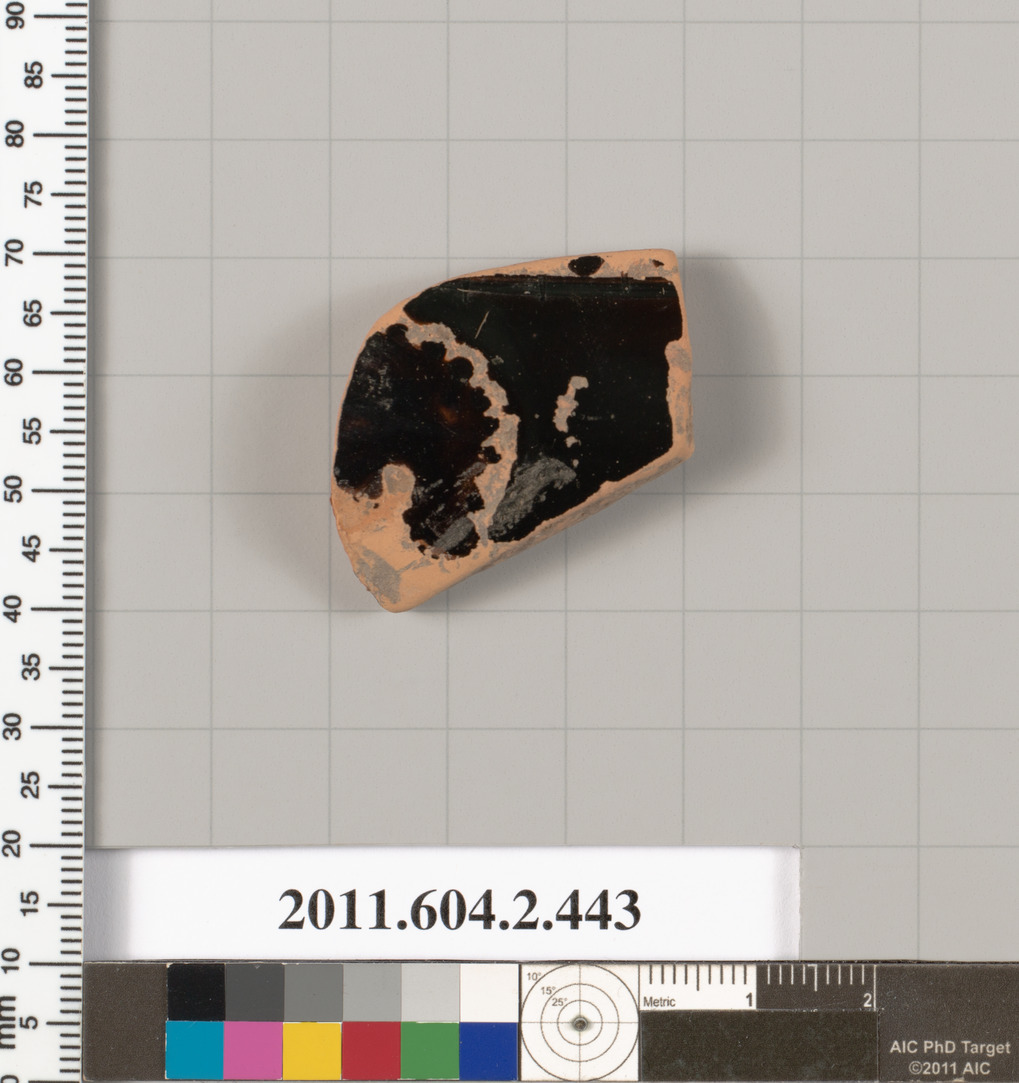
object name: column krater fragment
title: Terracotta fragment of a column-krater (bowl for mixing wine and water)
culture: greek, attic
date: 490-480 BCE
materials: terracotta